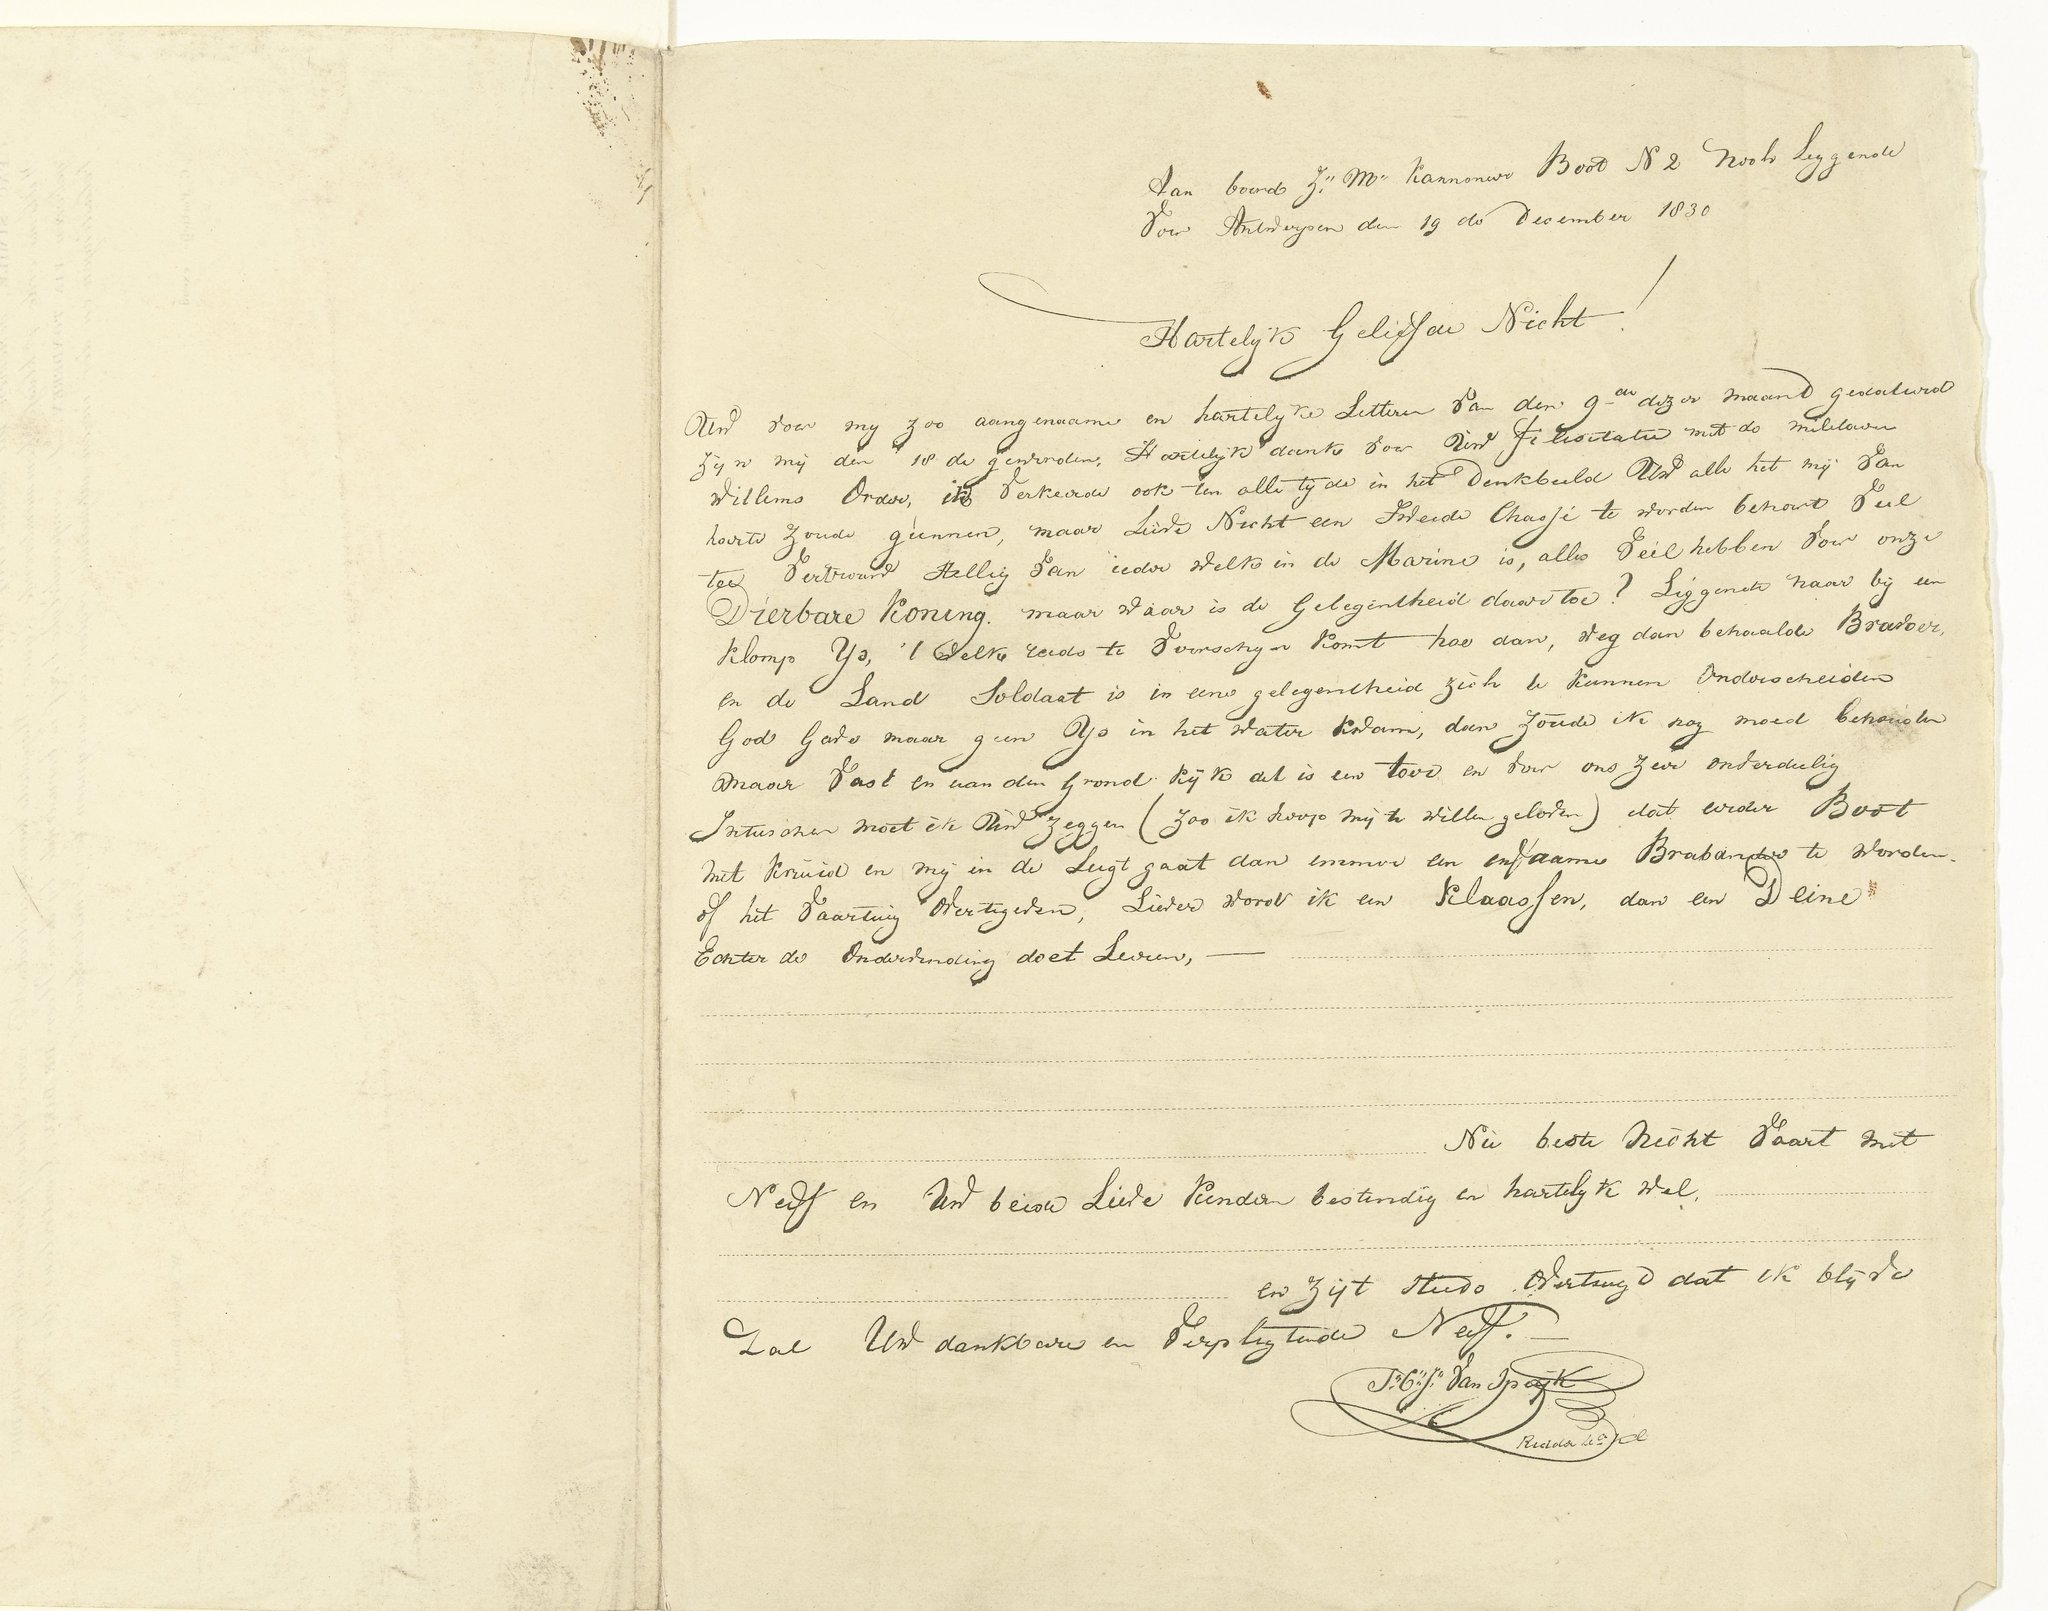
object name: facsimile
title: Facsimile van een brief van J.C.J. van Speyk aan zijn nicht mevrouw De Dieu van Tongeren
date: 1830-1832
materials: paper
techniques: lithograph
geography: amsterdam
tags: amsterdam, antwerp, jan van speyk